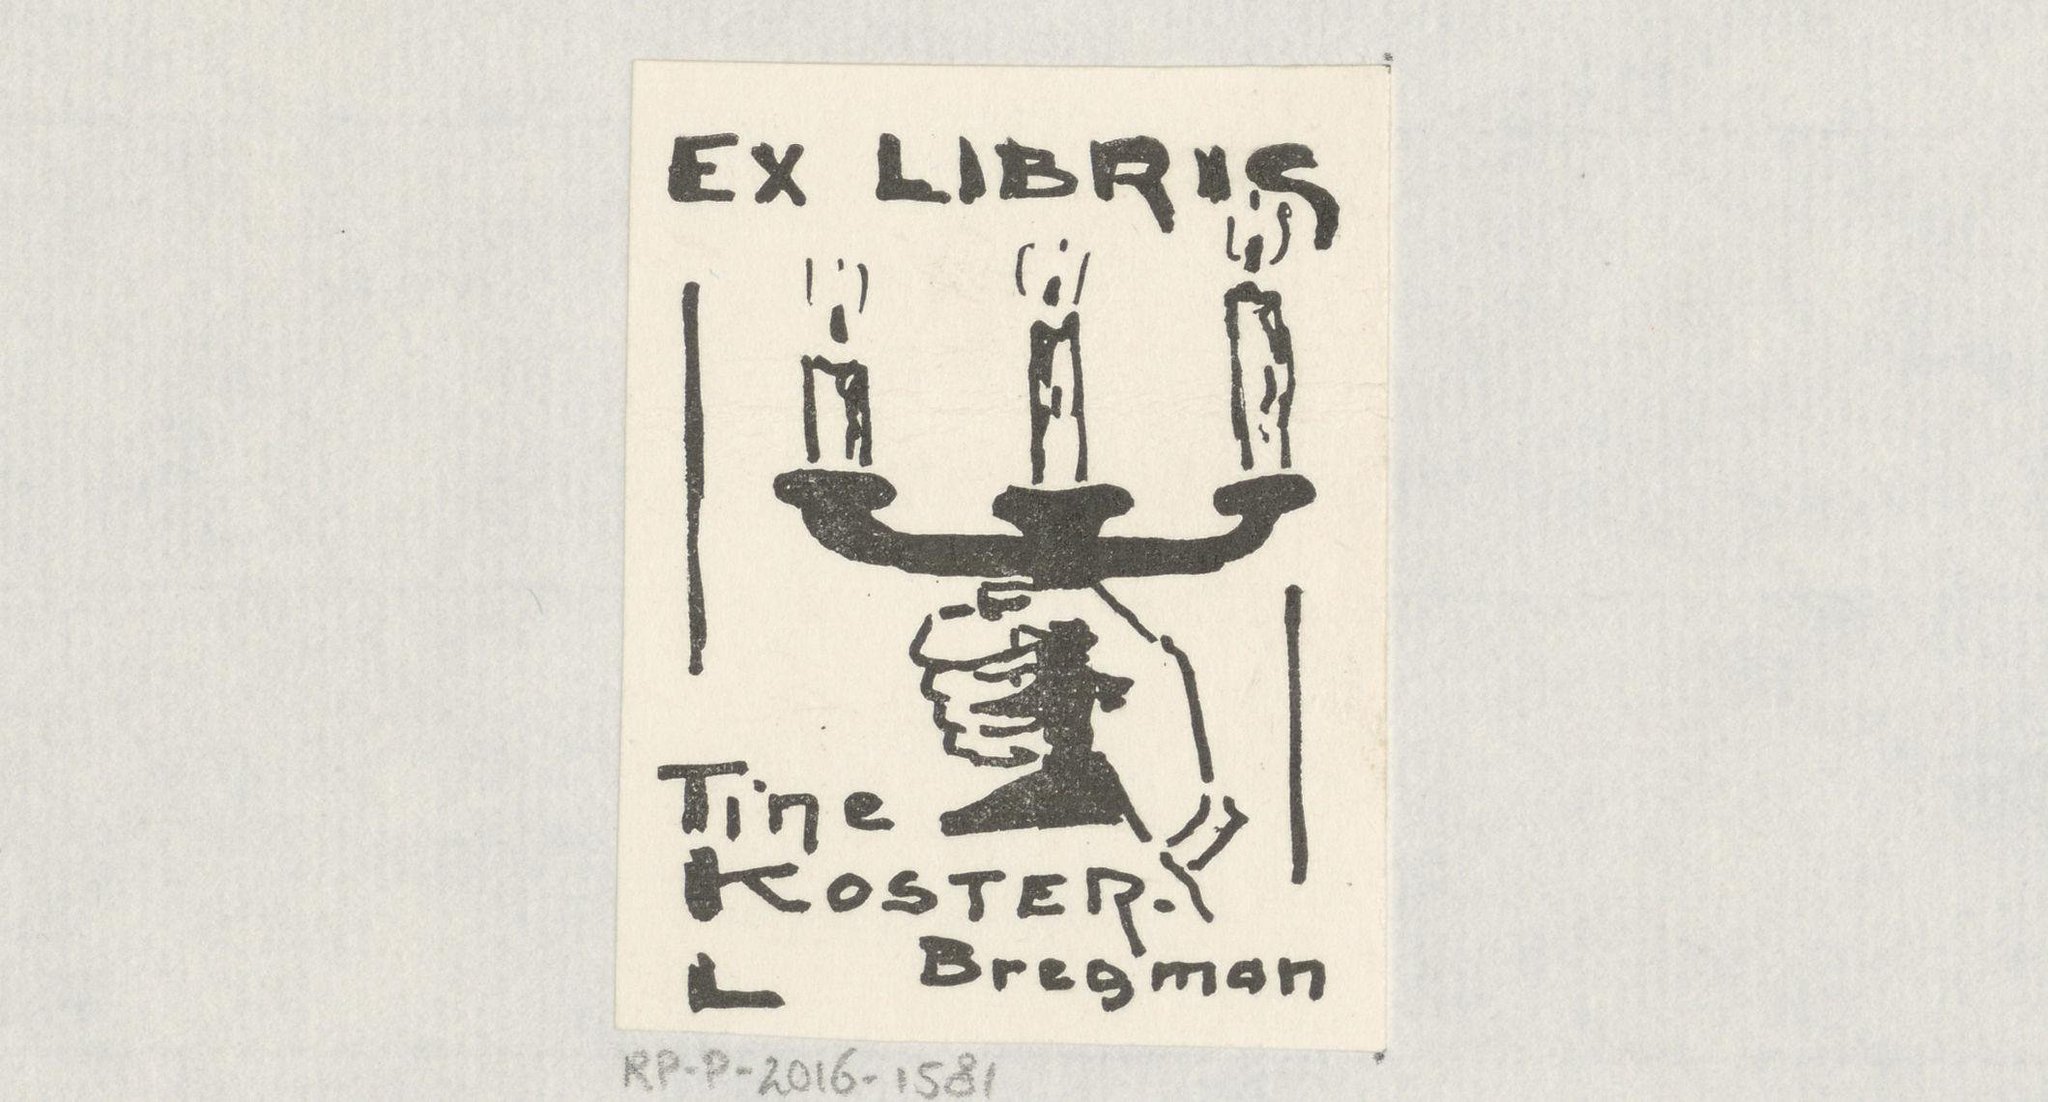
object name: bookplate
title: Ex libris van Tine Koster-Bregman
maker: c. bregman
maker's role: print maker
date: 1900-1999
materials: paper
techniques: printing block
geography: netherlands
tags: chandelier, candelabrum